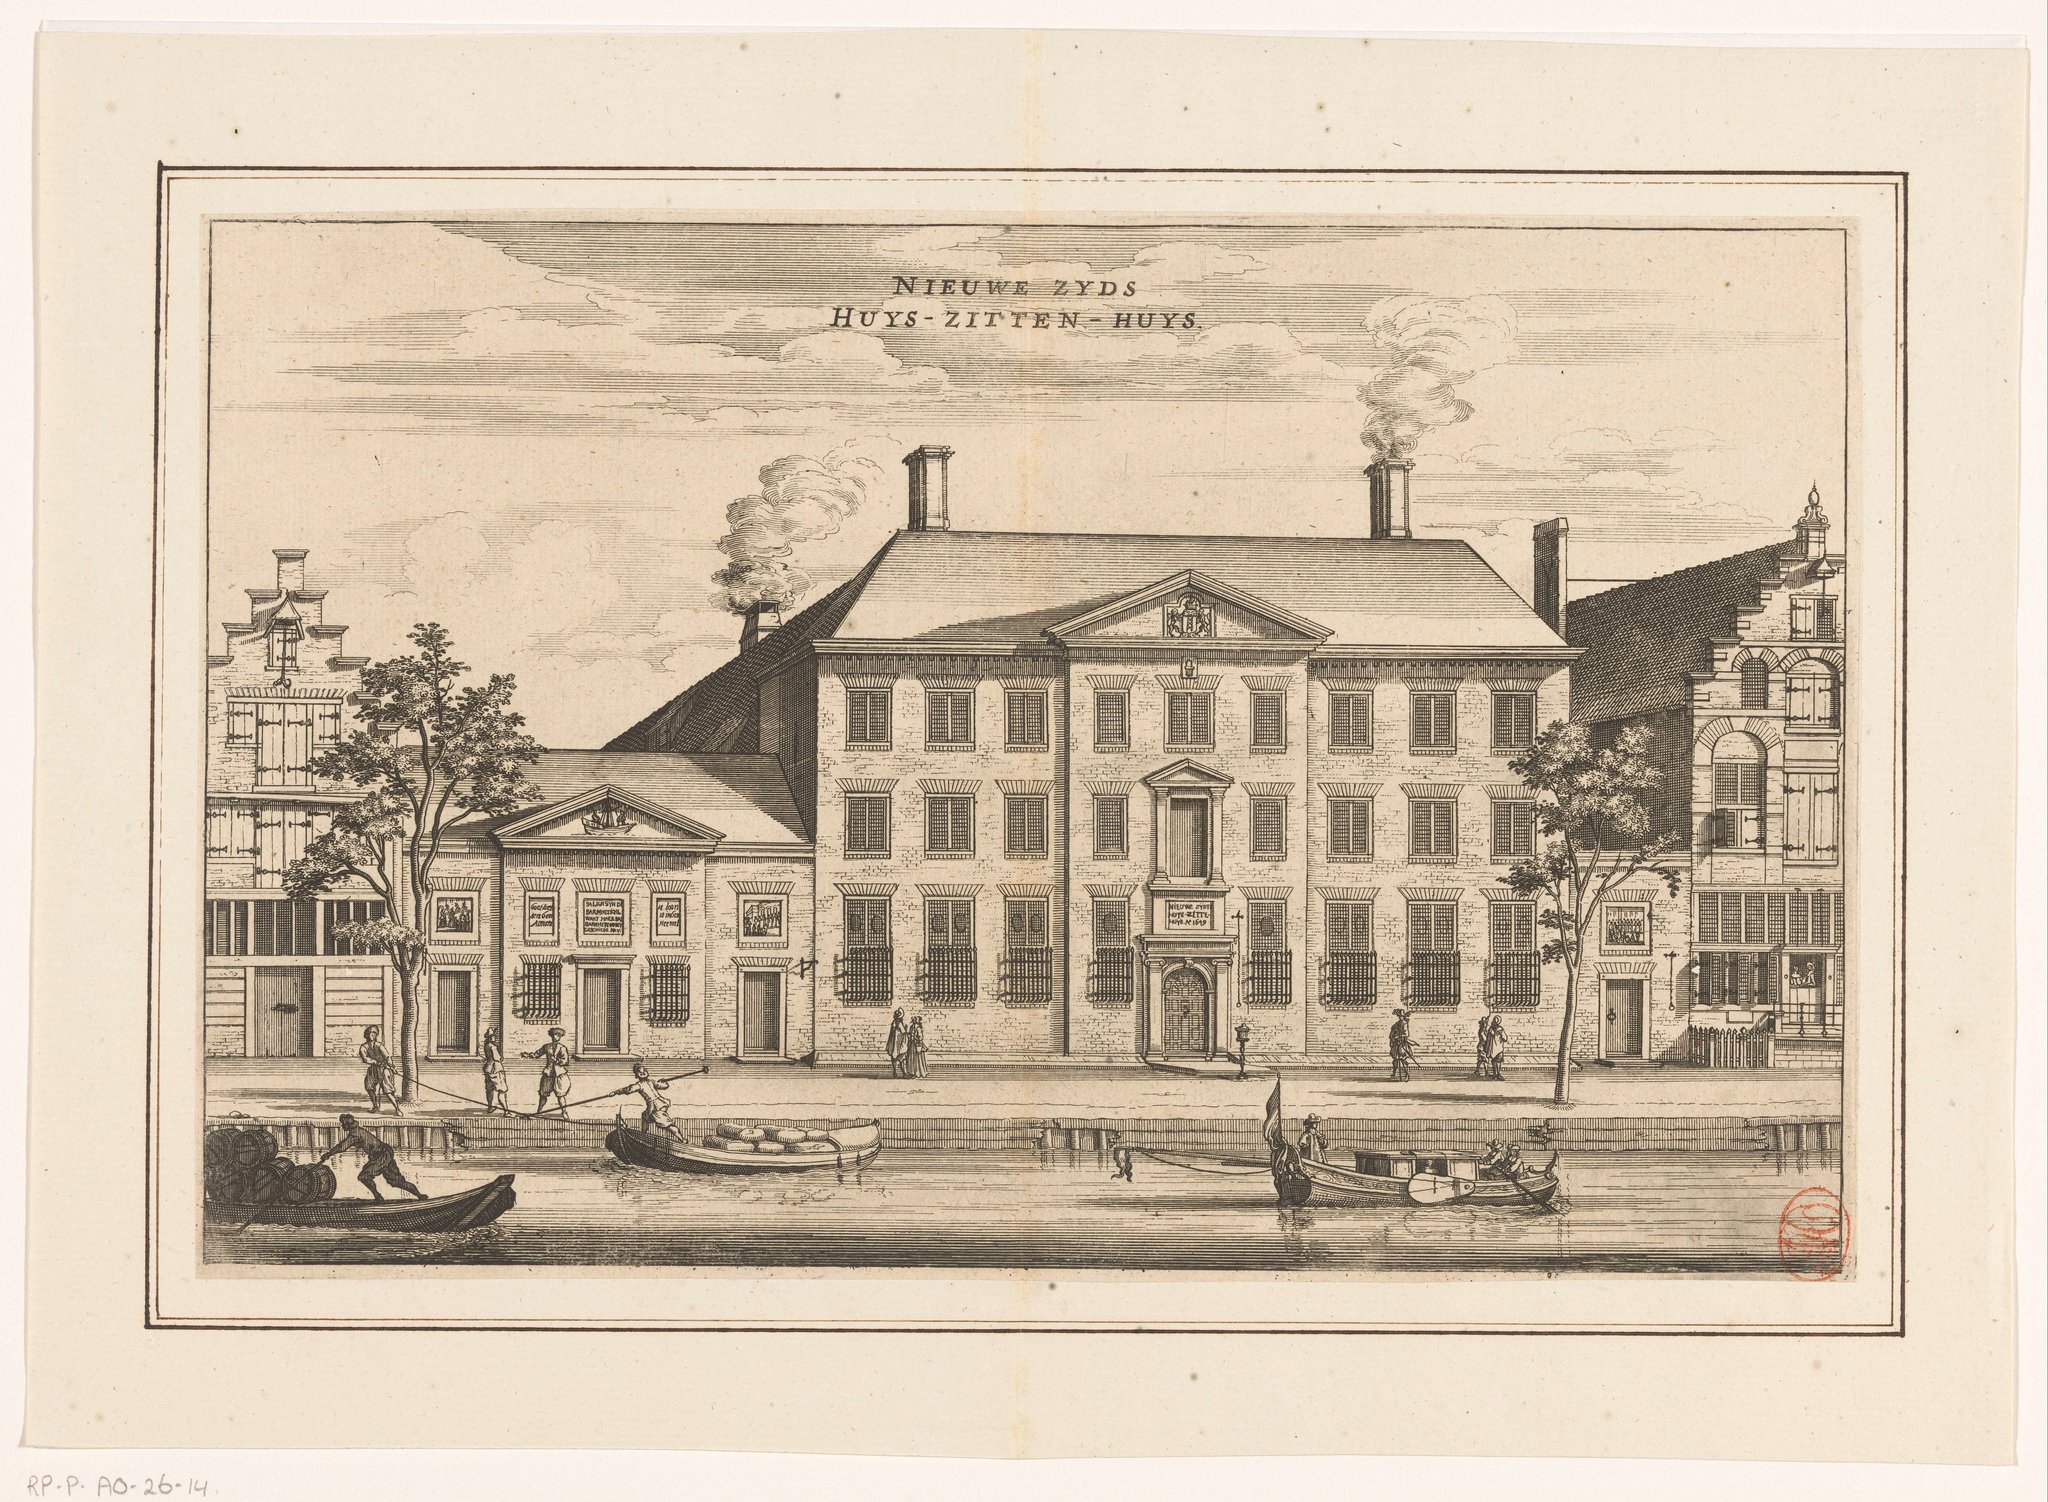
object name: book illustration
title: Gezicht op het Nieuwezijds Huiszittenhuis te Amsterdam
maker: jacob van meurs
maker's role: draughtsman, print maker, publisher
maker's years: 1619-1680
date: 1663-1664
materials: paper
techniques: etching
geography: amsterdam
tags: public welfare, poorhouse, canals, waters (in city) (+ city(-scape) with figures, staffage), street (+ city(-scape) with figures, staffage)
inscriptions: collector's mark: Lugt 195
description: Huidige staat van prent ook gebruikt in: Dapper, Olfert. Historische beschryving der stadt Amsterdam: waer in de voornaemste geschiedenissen (na een kort verhael van gansch Hollant en d'omleggende dorpen (…). Amsterdam: Jacob van Meurs, 1663.* En in: Zesen, Philipp von. Beschreibung der Stadt Amsterdam: darinnen von derselben ersten Ursprunge bis auf gegenwärtigen Zustand (…). Amsterdam: Joachim Nosche, 1664. * In sommige exemplaren van deze uitgave komt de huidige staat van de prent voor. In andere exemplaren is een latere staat ingebonden, waarop boven de Nederlandse een Franse titel is toegevoegd.